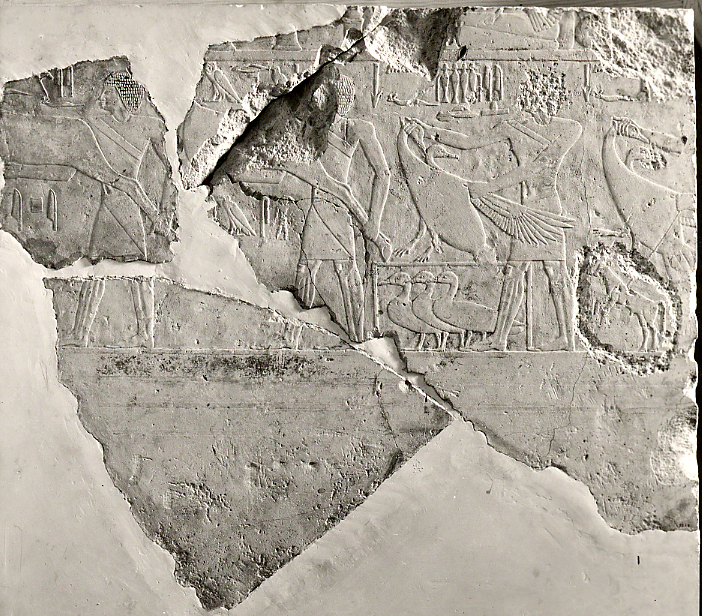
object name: relief, mastaba of rehuerdjersen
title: Relief fragment from mastaba of Rehuerdjersen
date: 2030-1640 BCE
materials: limestone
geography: egypt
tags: animals,birds,men